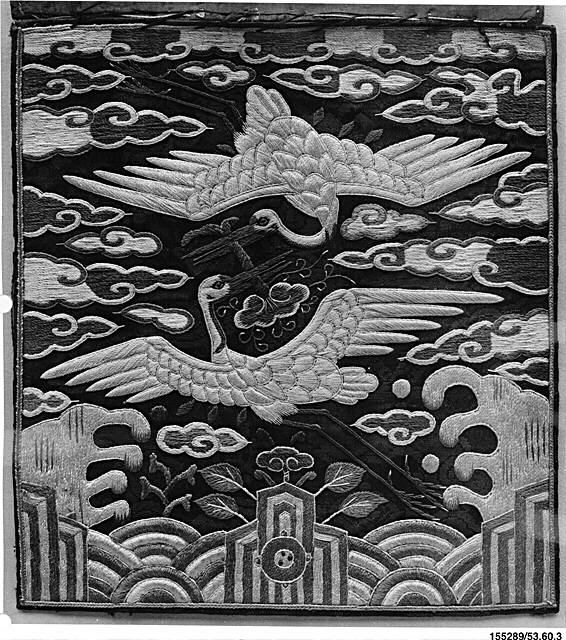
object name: rank badge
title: Rank Badge with Decoration of Two Cranes among Clouds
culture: korean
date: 1801-1900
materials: silk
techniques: damask, embroidery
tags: cranes